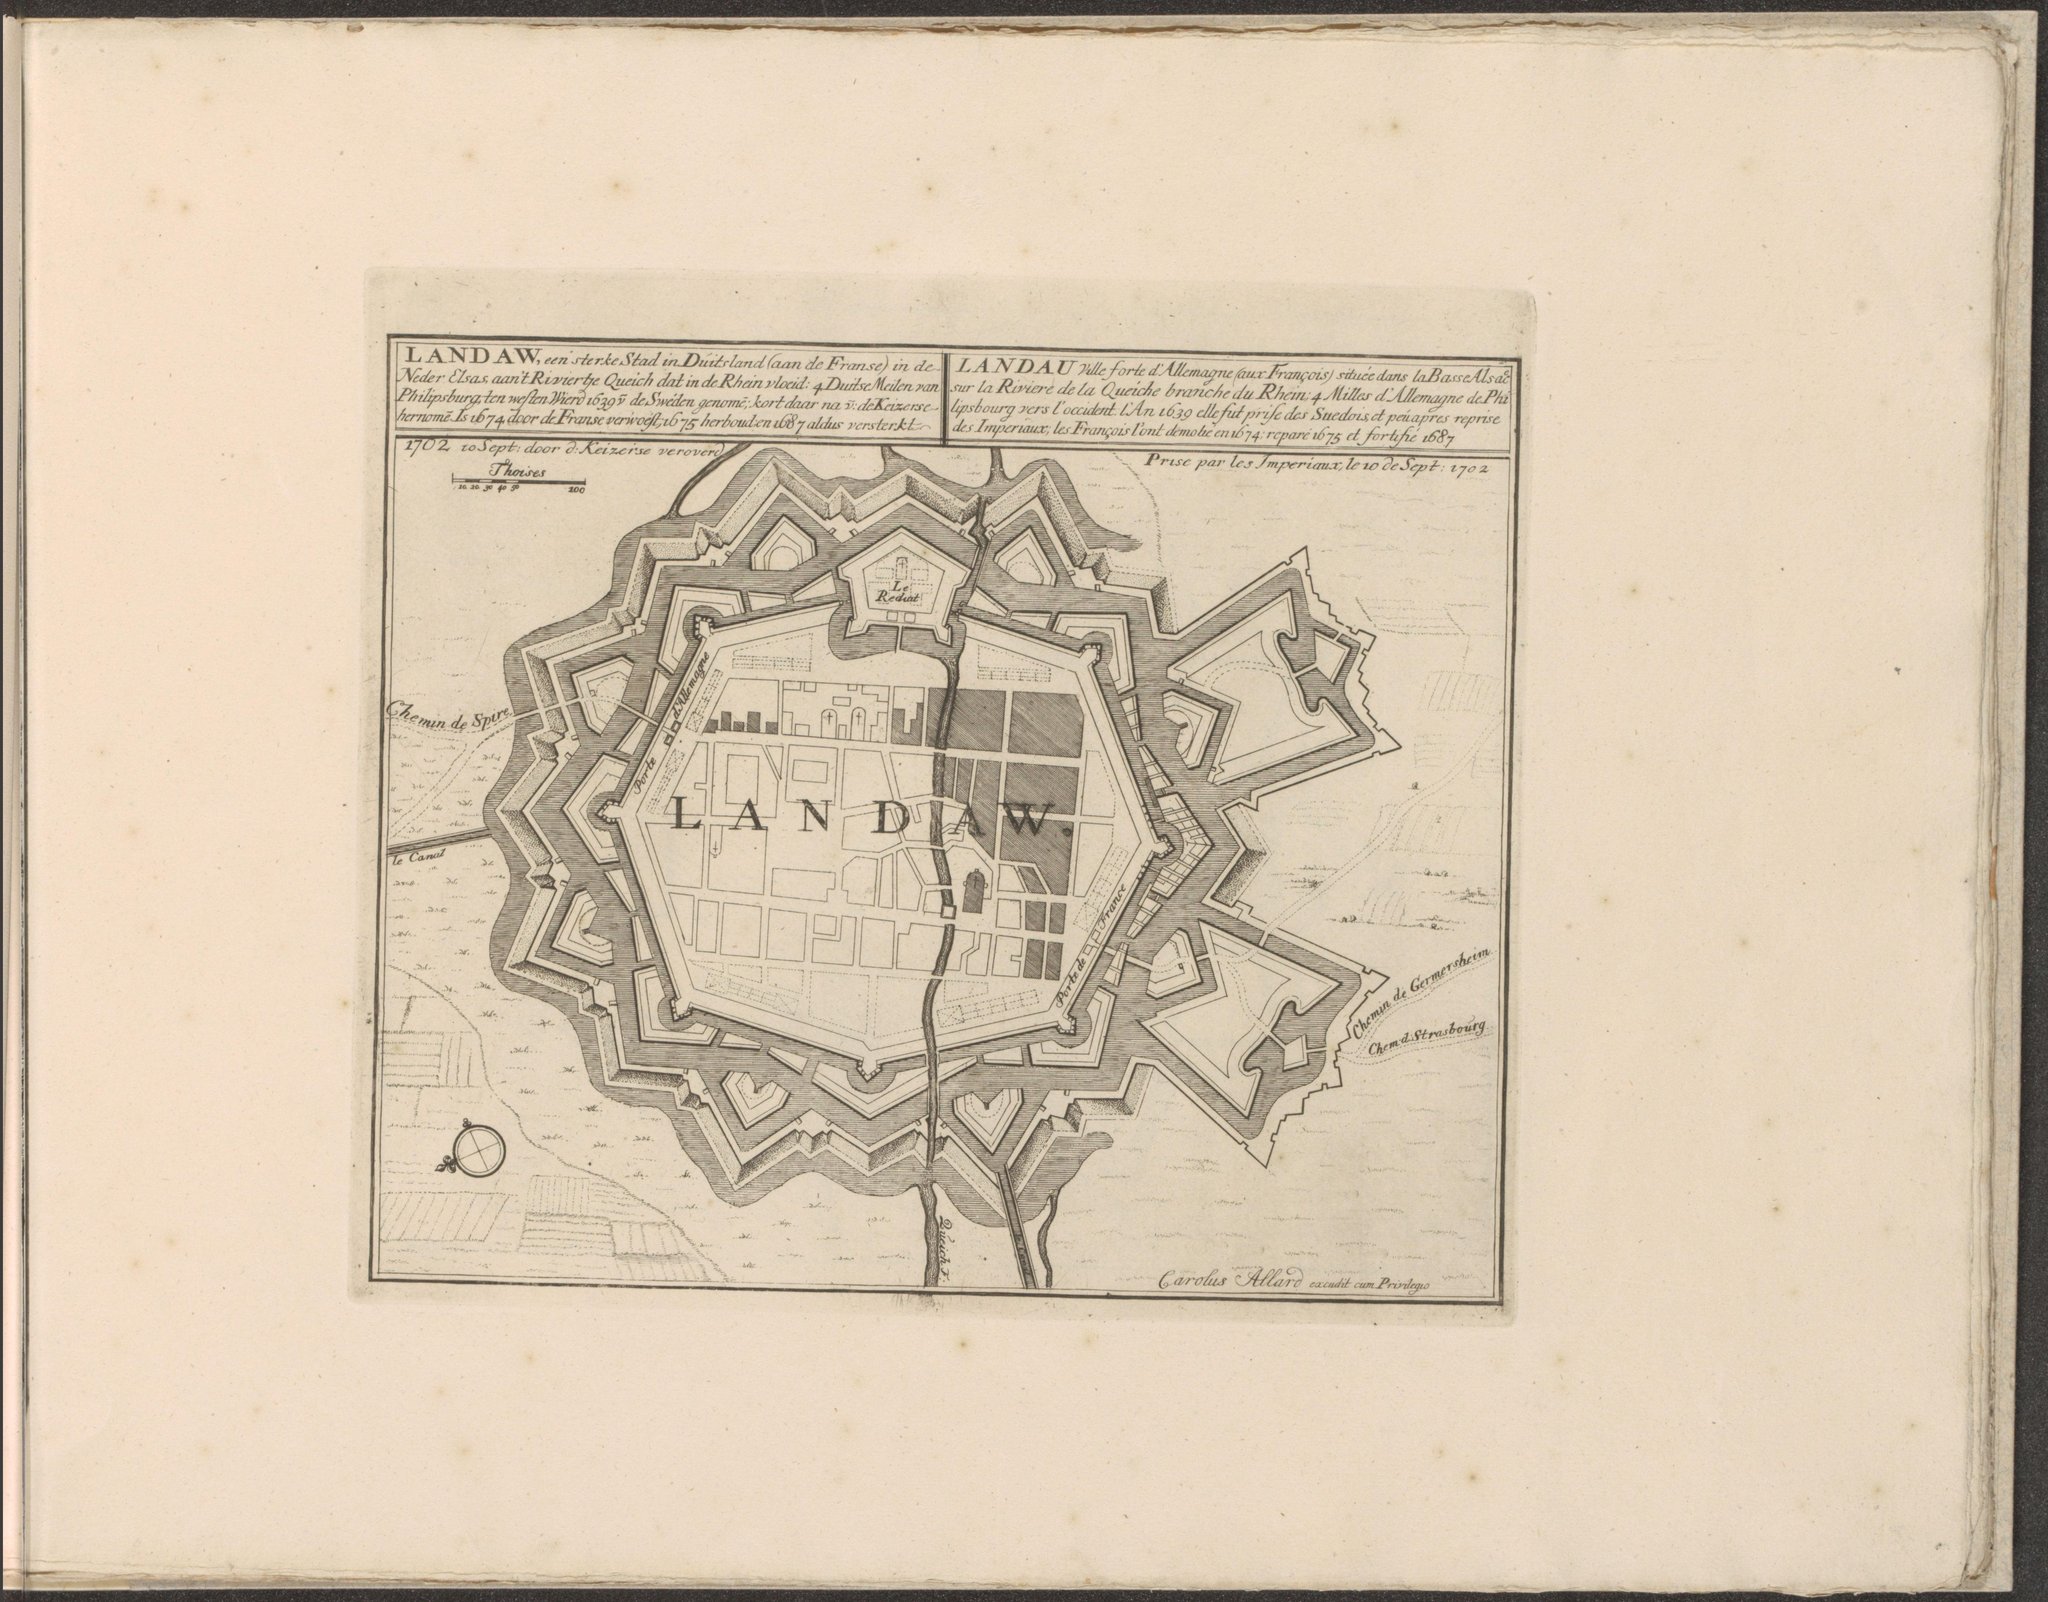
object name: album leaf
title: Plattegrond van Landau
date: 1702-1733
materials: paper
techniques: etching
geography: leiden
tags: fortifications, military engineering, maps of cities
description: Plattegrond van de stad Landau, veroverd op de Fransen door de keizerlijke troepen op 10 september 1702. Met teksten in het Nederlands en Frans. De prent maakt deel uit van een album.